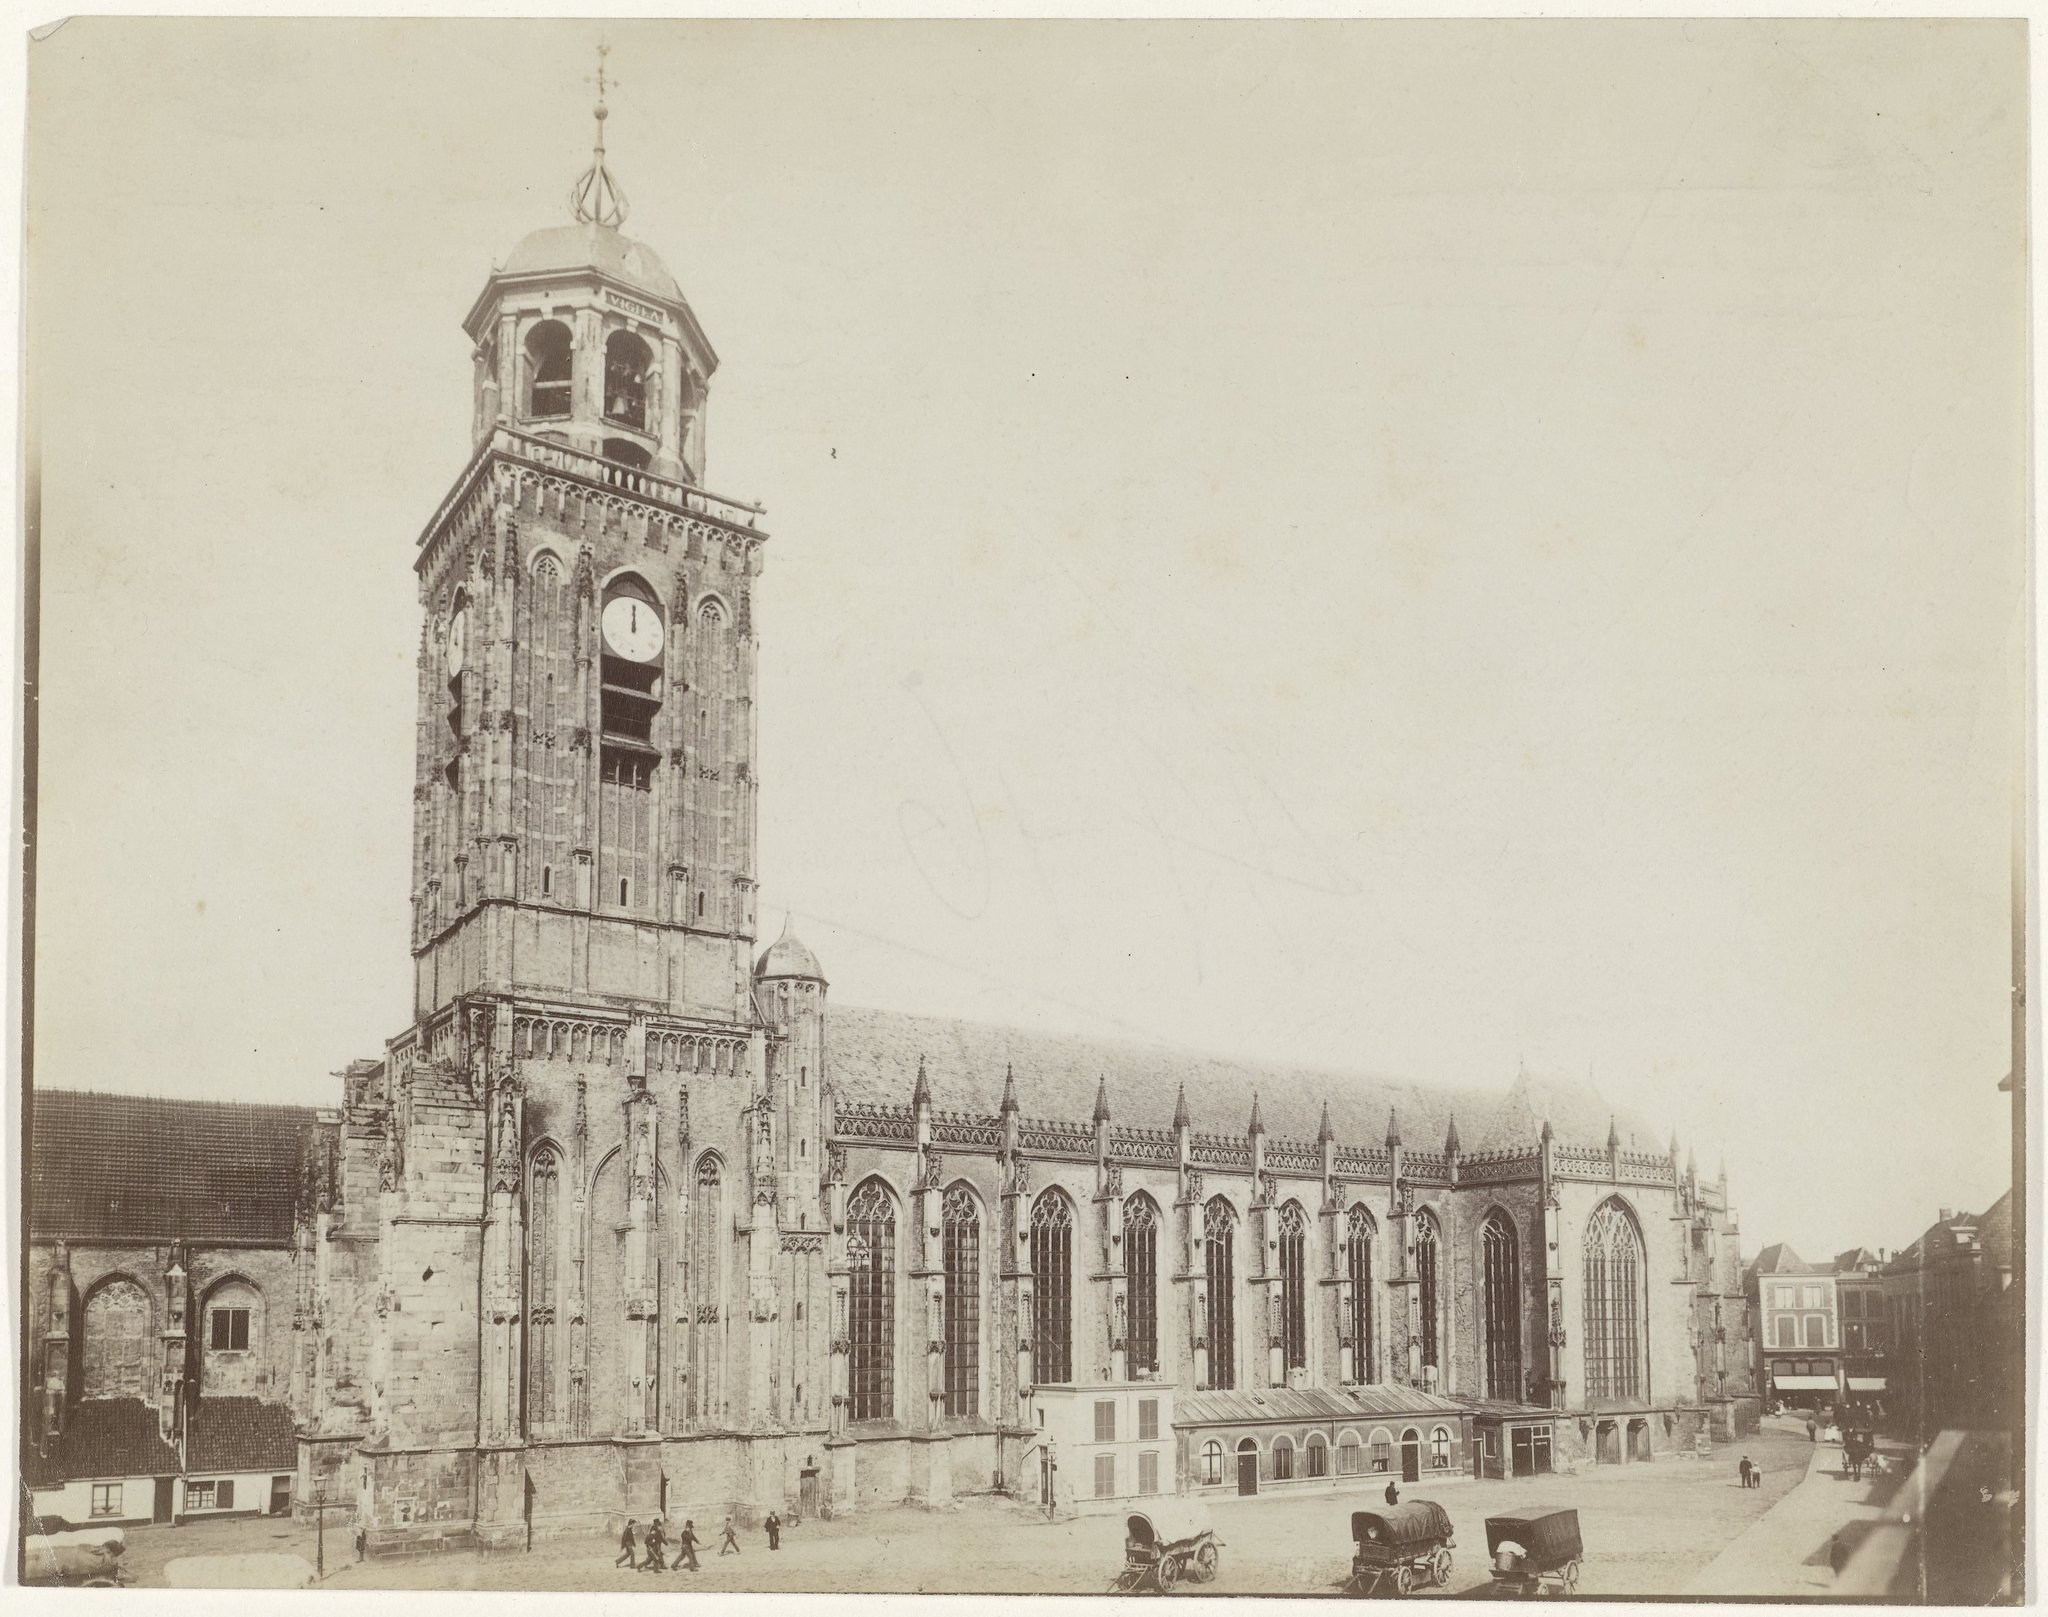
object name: photograph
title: Libuinuskerk in Deventer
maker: Anonymous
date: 1850-1880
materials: photographic support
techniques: albumen print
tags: deventer